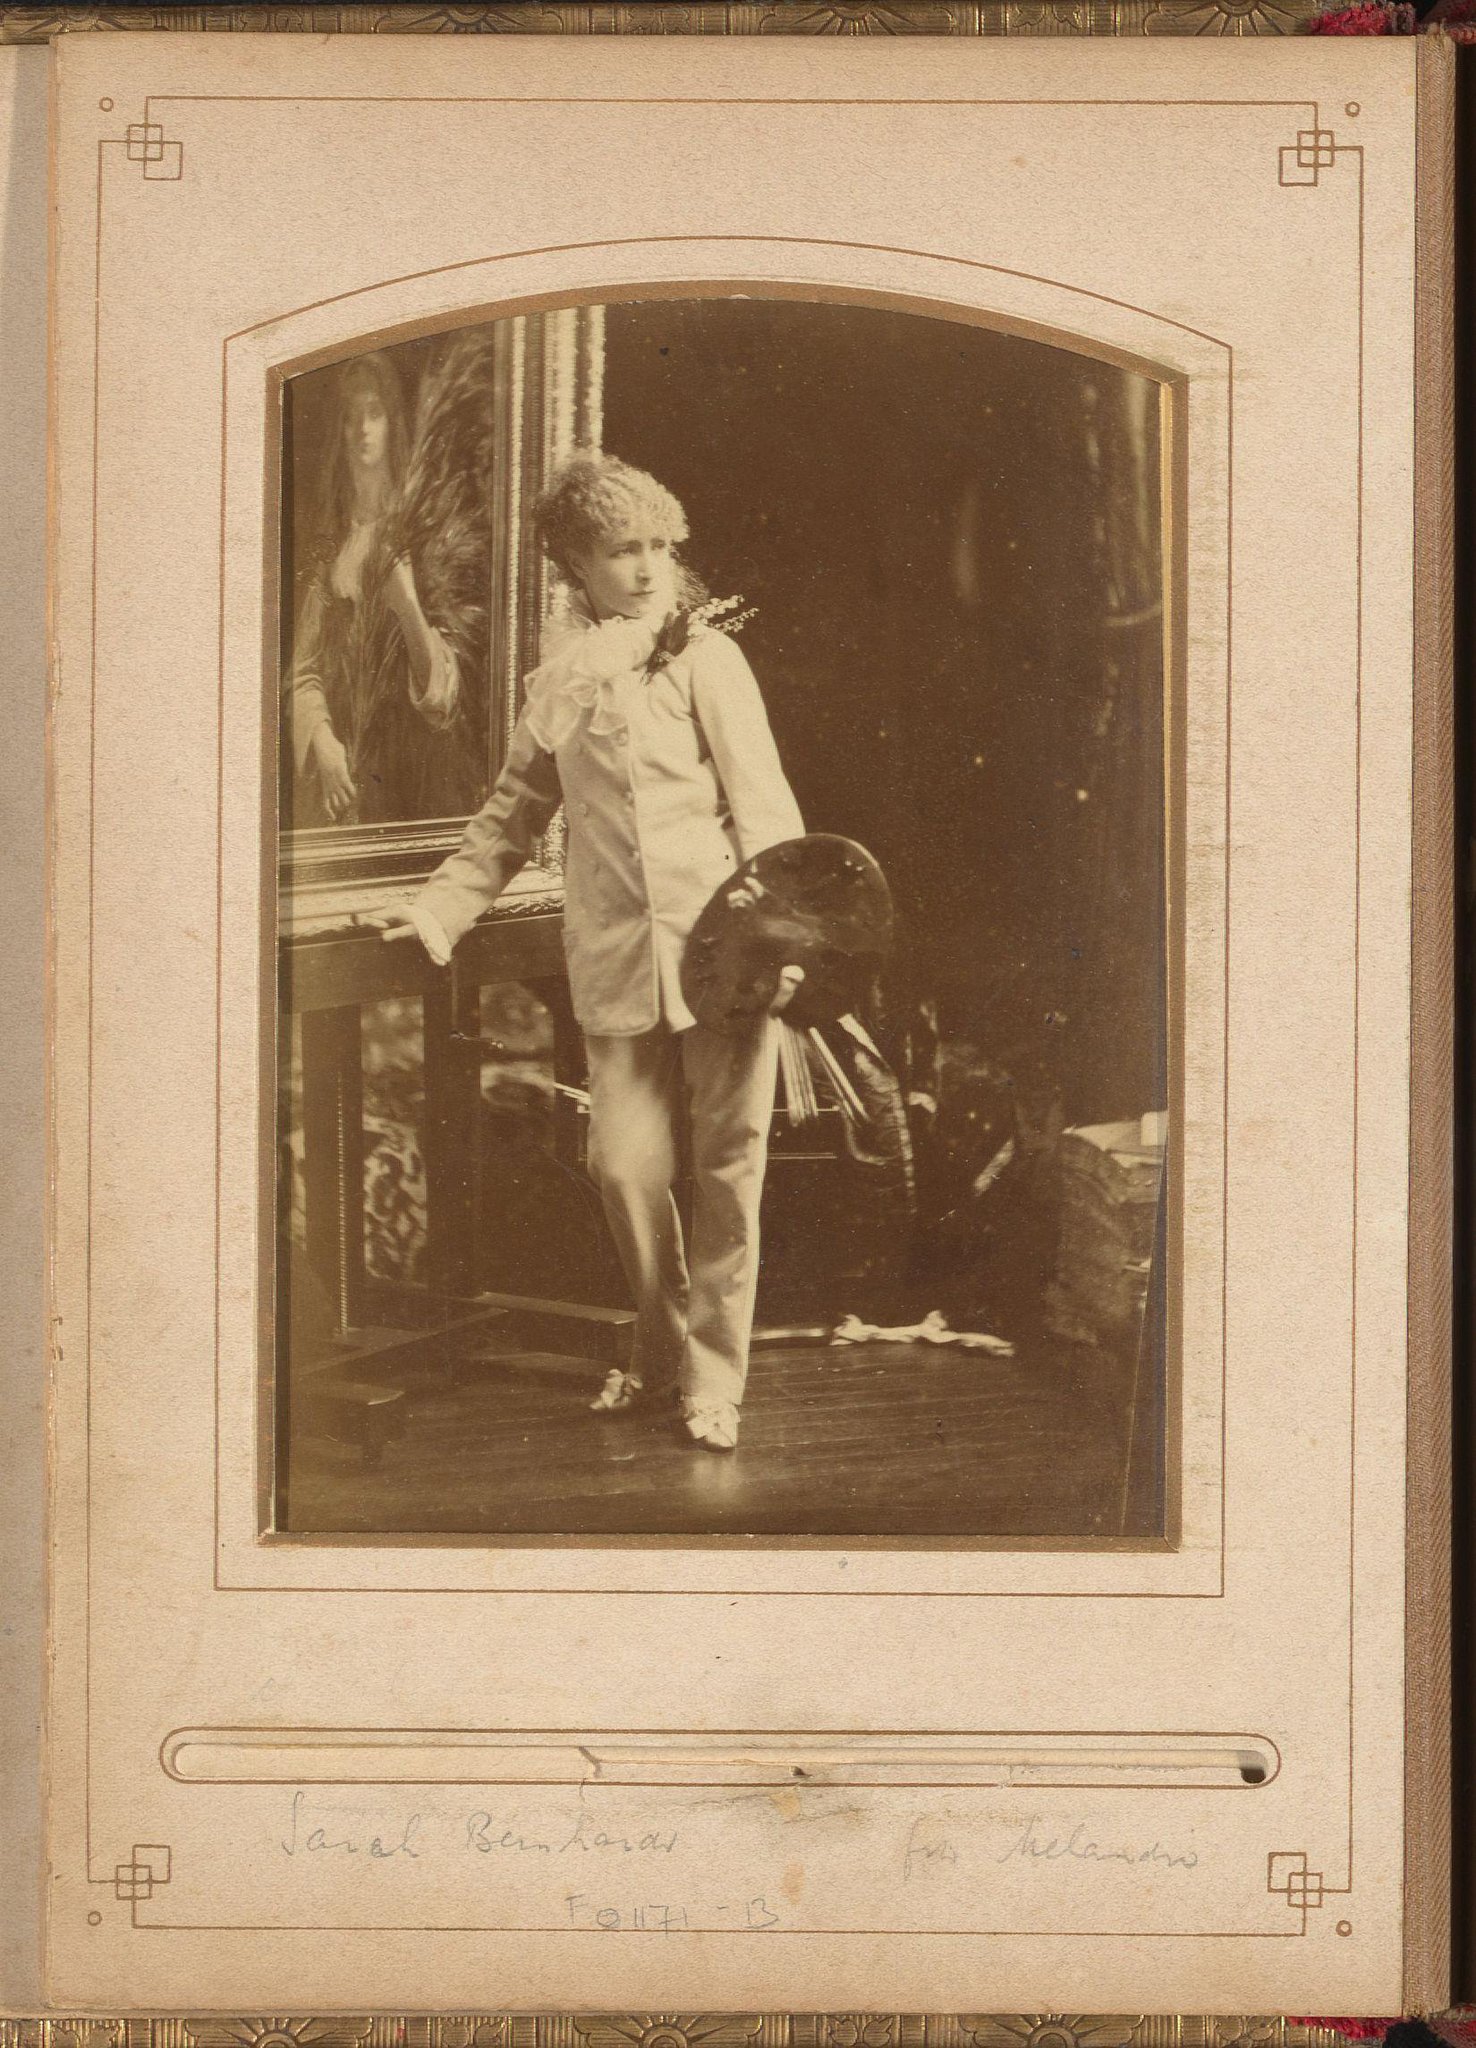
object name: cabinet photograph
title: Portret van Sarah Bernhardt als schilder met palet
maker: achille mélandri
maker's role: publisher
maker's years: 1845-1905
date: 1870-1890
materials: cardboard, photographic support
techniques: albumen print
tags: paris, sculptor, sarah bernhardt, adult woman, portrait of actor, actress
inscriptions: inscription: ‘Paris, 19 Rue Clauzel’, name: ‘Melandri Paris’